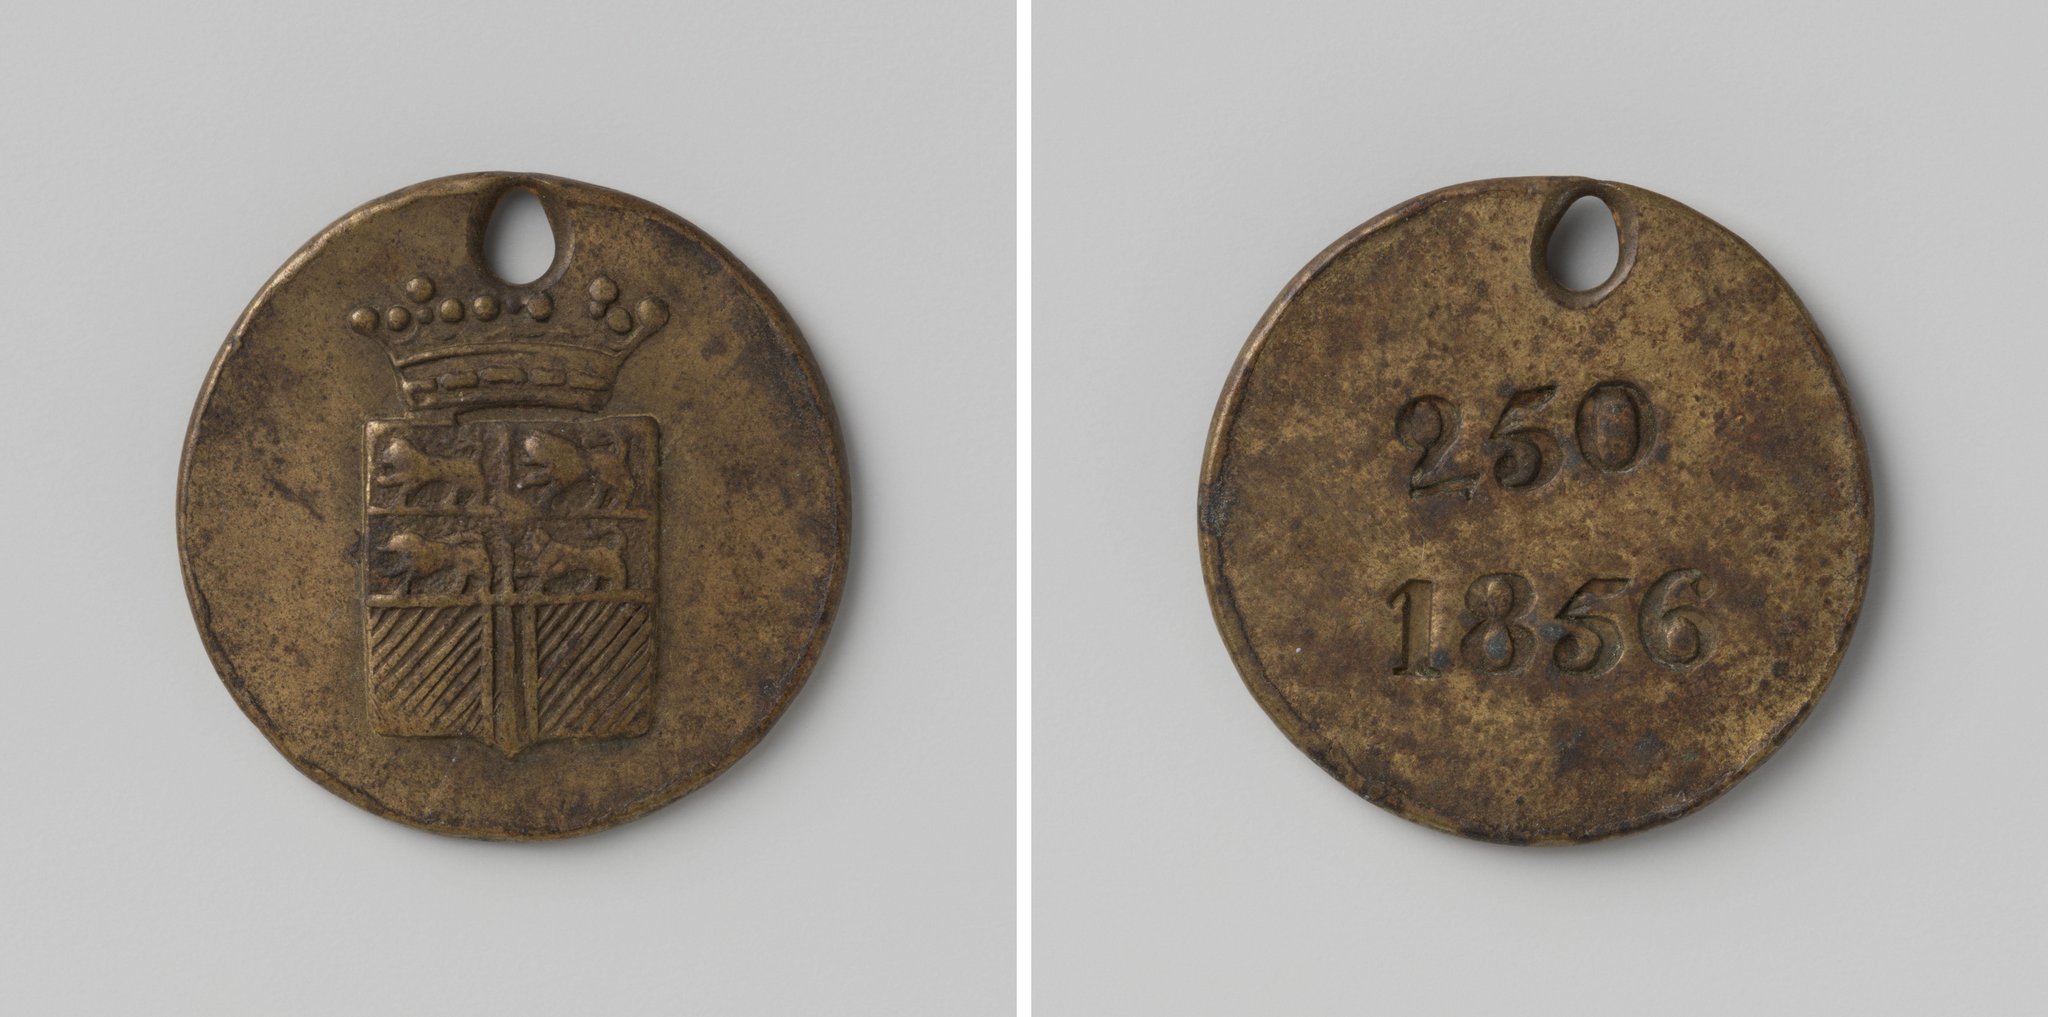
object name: tax token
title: Stad Rotterdam, loodje met no. 250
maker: Anonymous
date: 1856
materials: brass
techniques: striking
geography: rotterdam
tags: rotterdam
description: loodje met gat erin. Voorzijde: gekroond wapenschild. Keerzijde: cijfer no. 250 boven jaartal